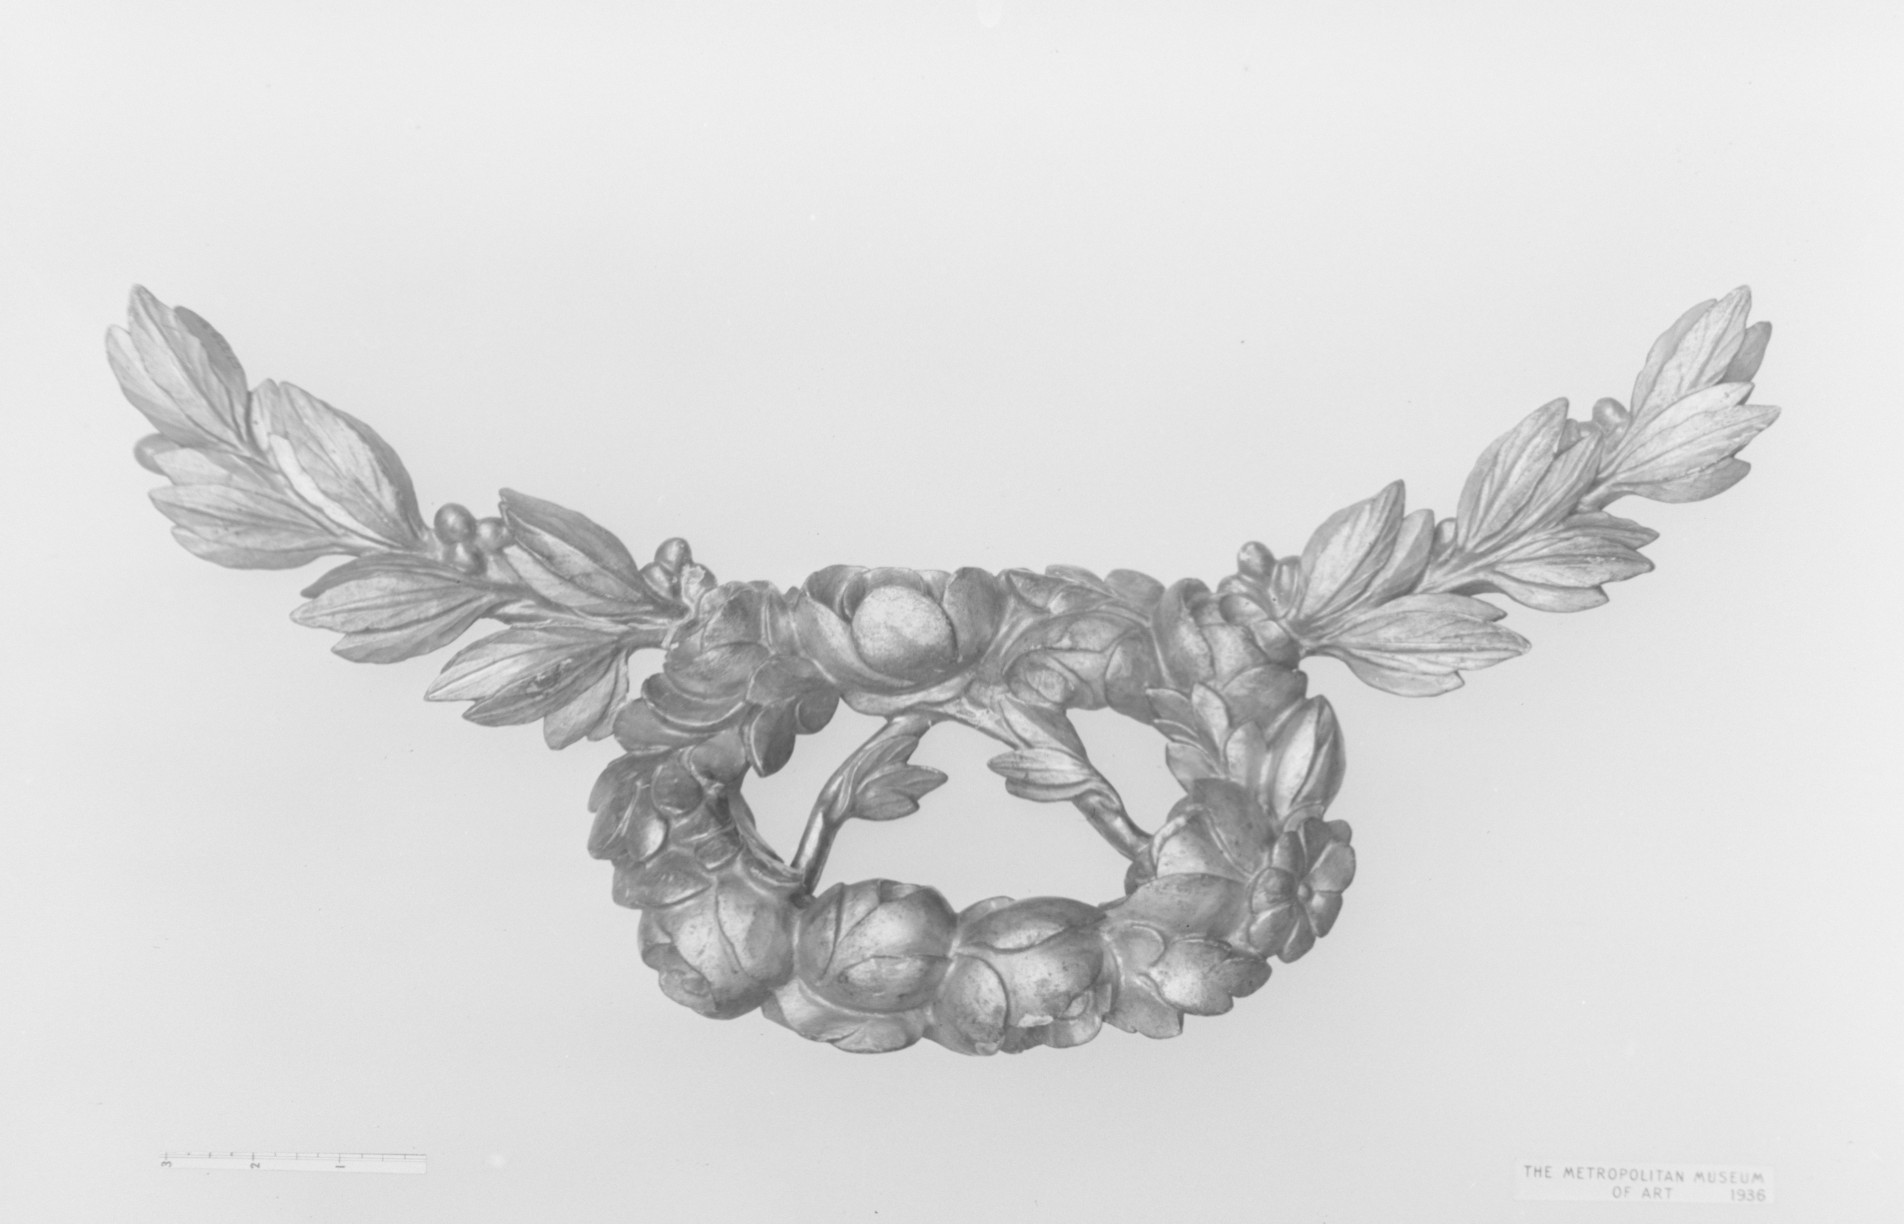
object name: wreath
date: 1701-1800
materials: wood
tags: flowers,wreaths